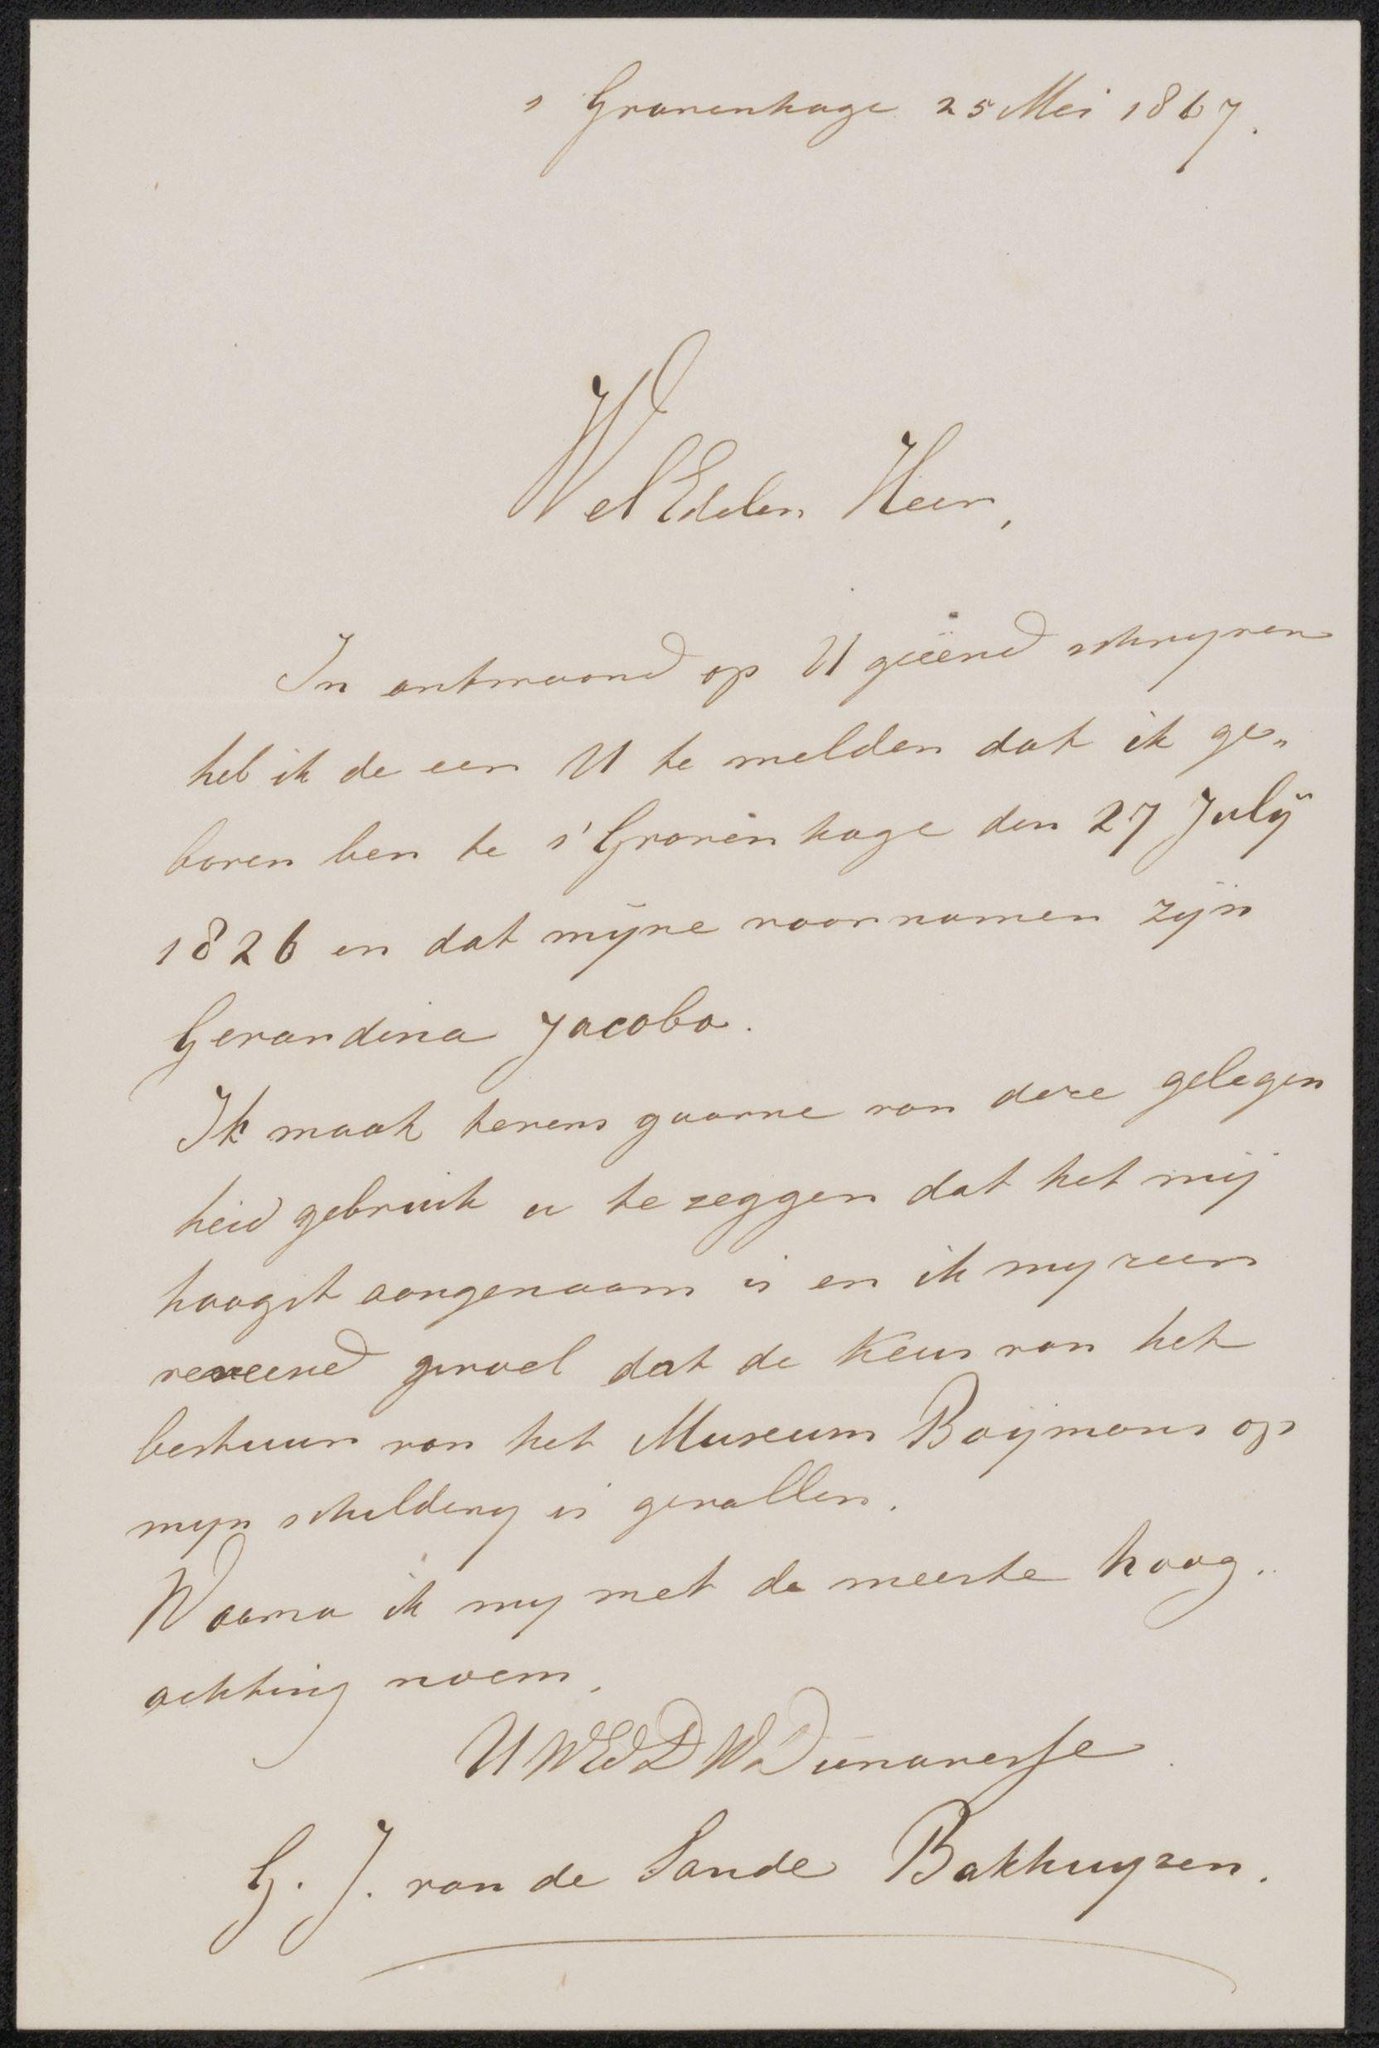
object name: letter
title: Brief aan Ary Johannes Lamme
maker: julius jacobus van de sande bakhuyzen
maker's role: draughtsman, painter, print maker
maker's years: 1835-1925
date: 1867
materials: ink, paper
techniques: pen, writing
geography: the hague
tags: dordrecht, ary johannes lamme, painting (including book-illumination, miniature-painting), art collecting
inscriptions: collector's mark: Lugt 2228